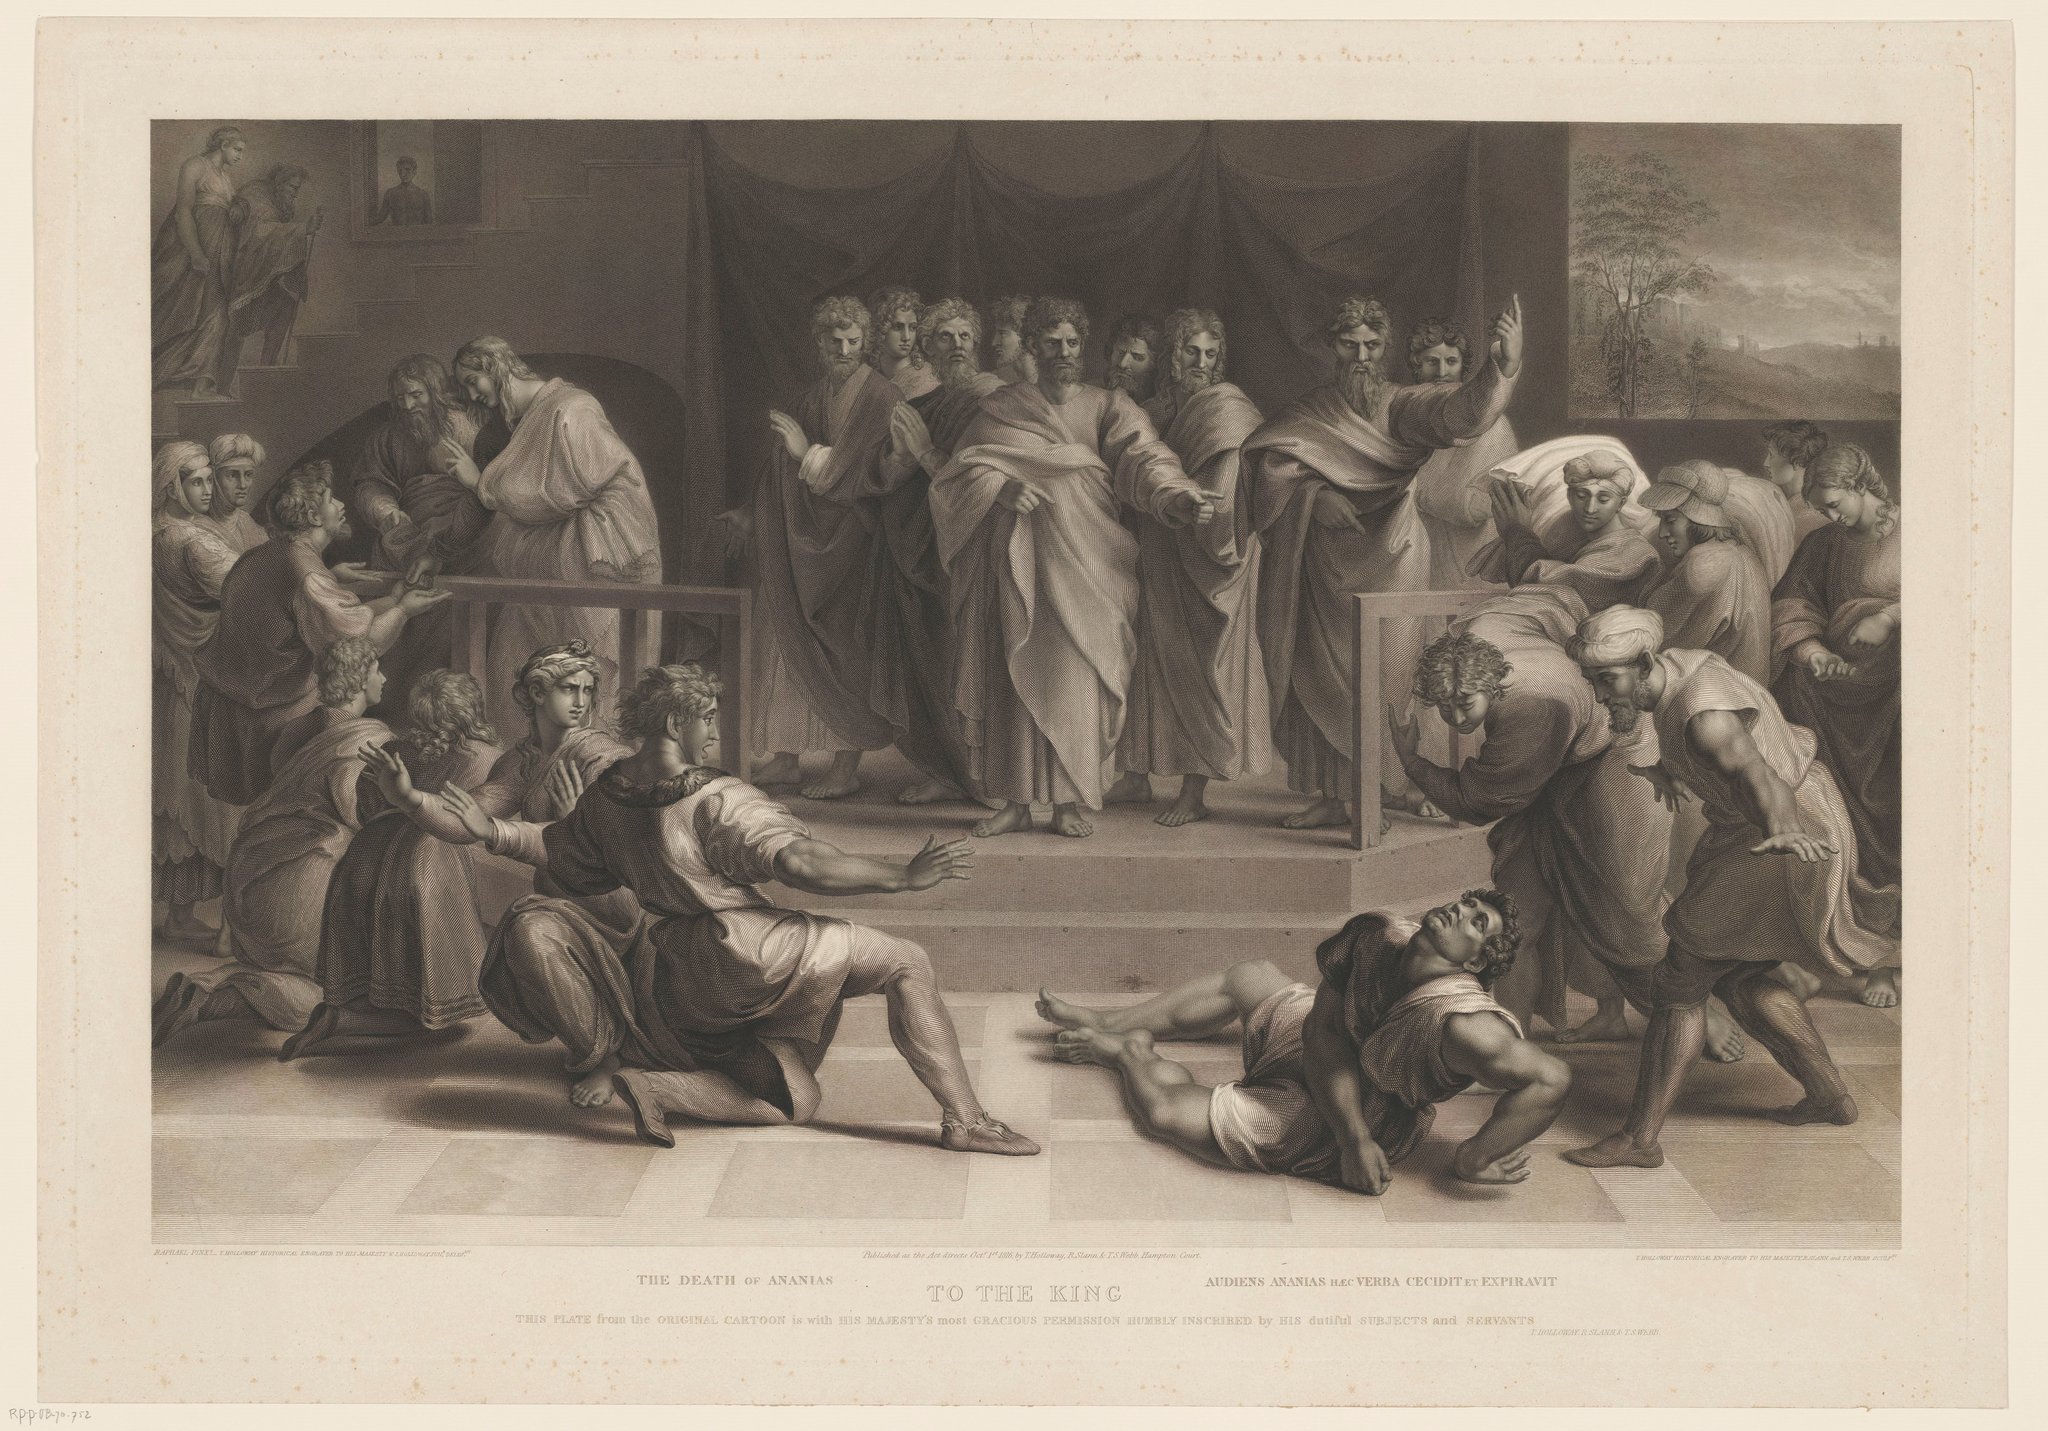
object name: print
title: Dood van Ananias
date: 1816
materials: paper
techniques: engraving, etching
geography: rome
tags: ananias, rebuked by peter, falls down and dies between his gifts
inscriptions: collector's mark: Lugt 12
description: Met drieregelig onderschrift in het Engels.